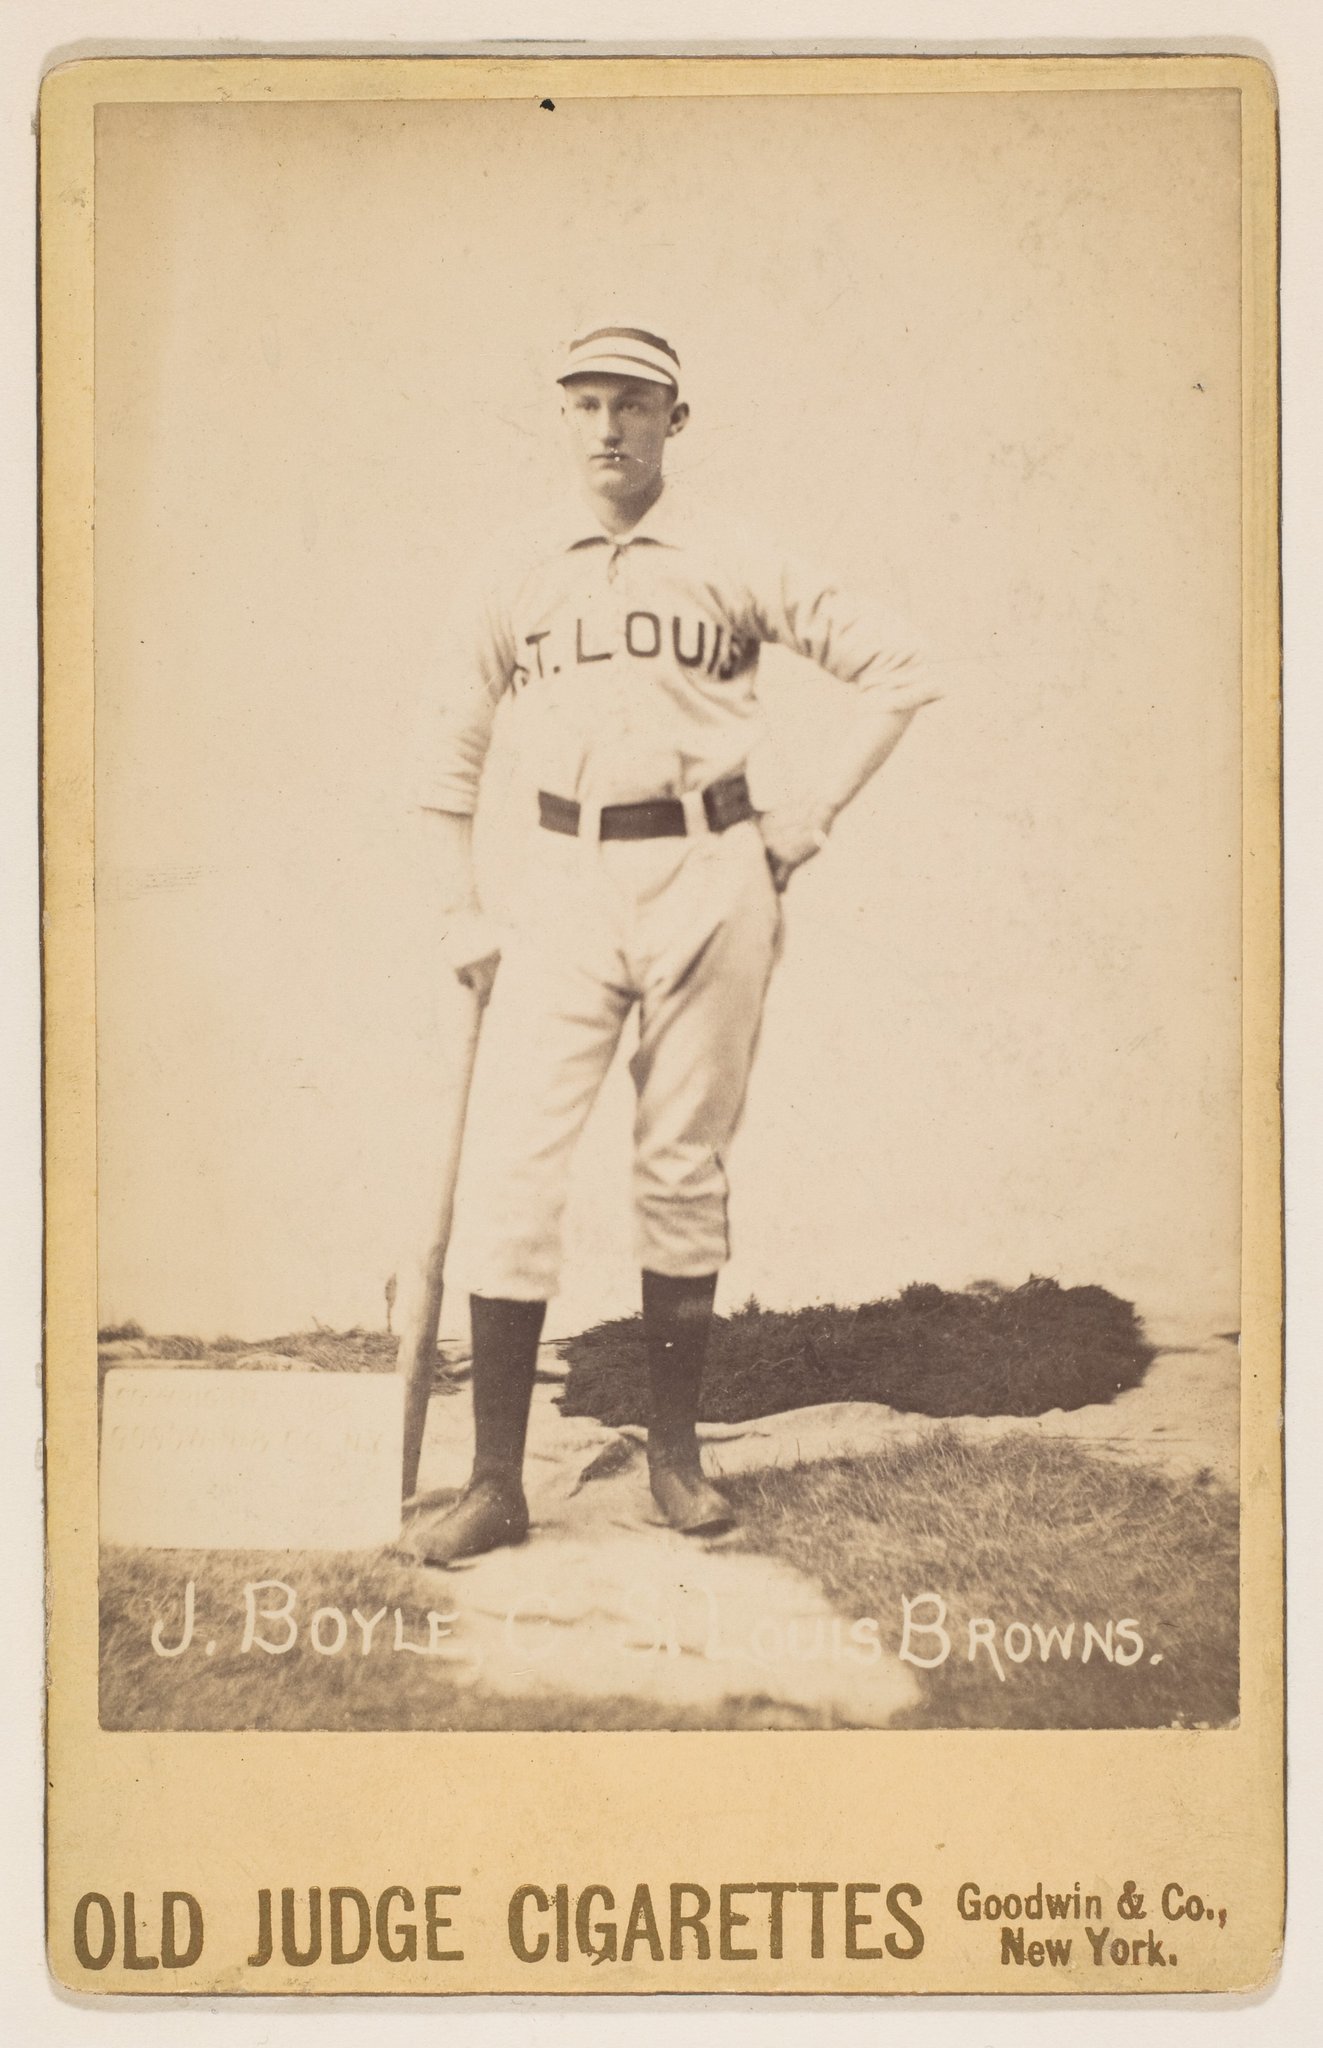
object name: baseball card, photograph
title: J. Boyle, Catcher, St. Louis Browns, from the series Old Judge Cigarettes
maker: goodwin & company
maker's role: publisher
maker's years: 1850-1950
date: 1887-1889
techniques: albumen print, photography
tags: men,portraits,baseball,athletes